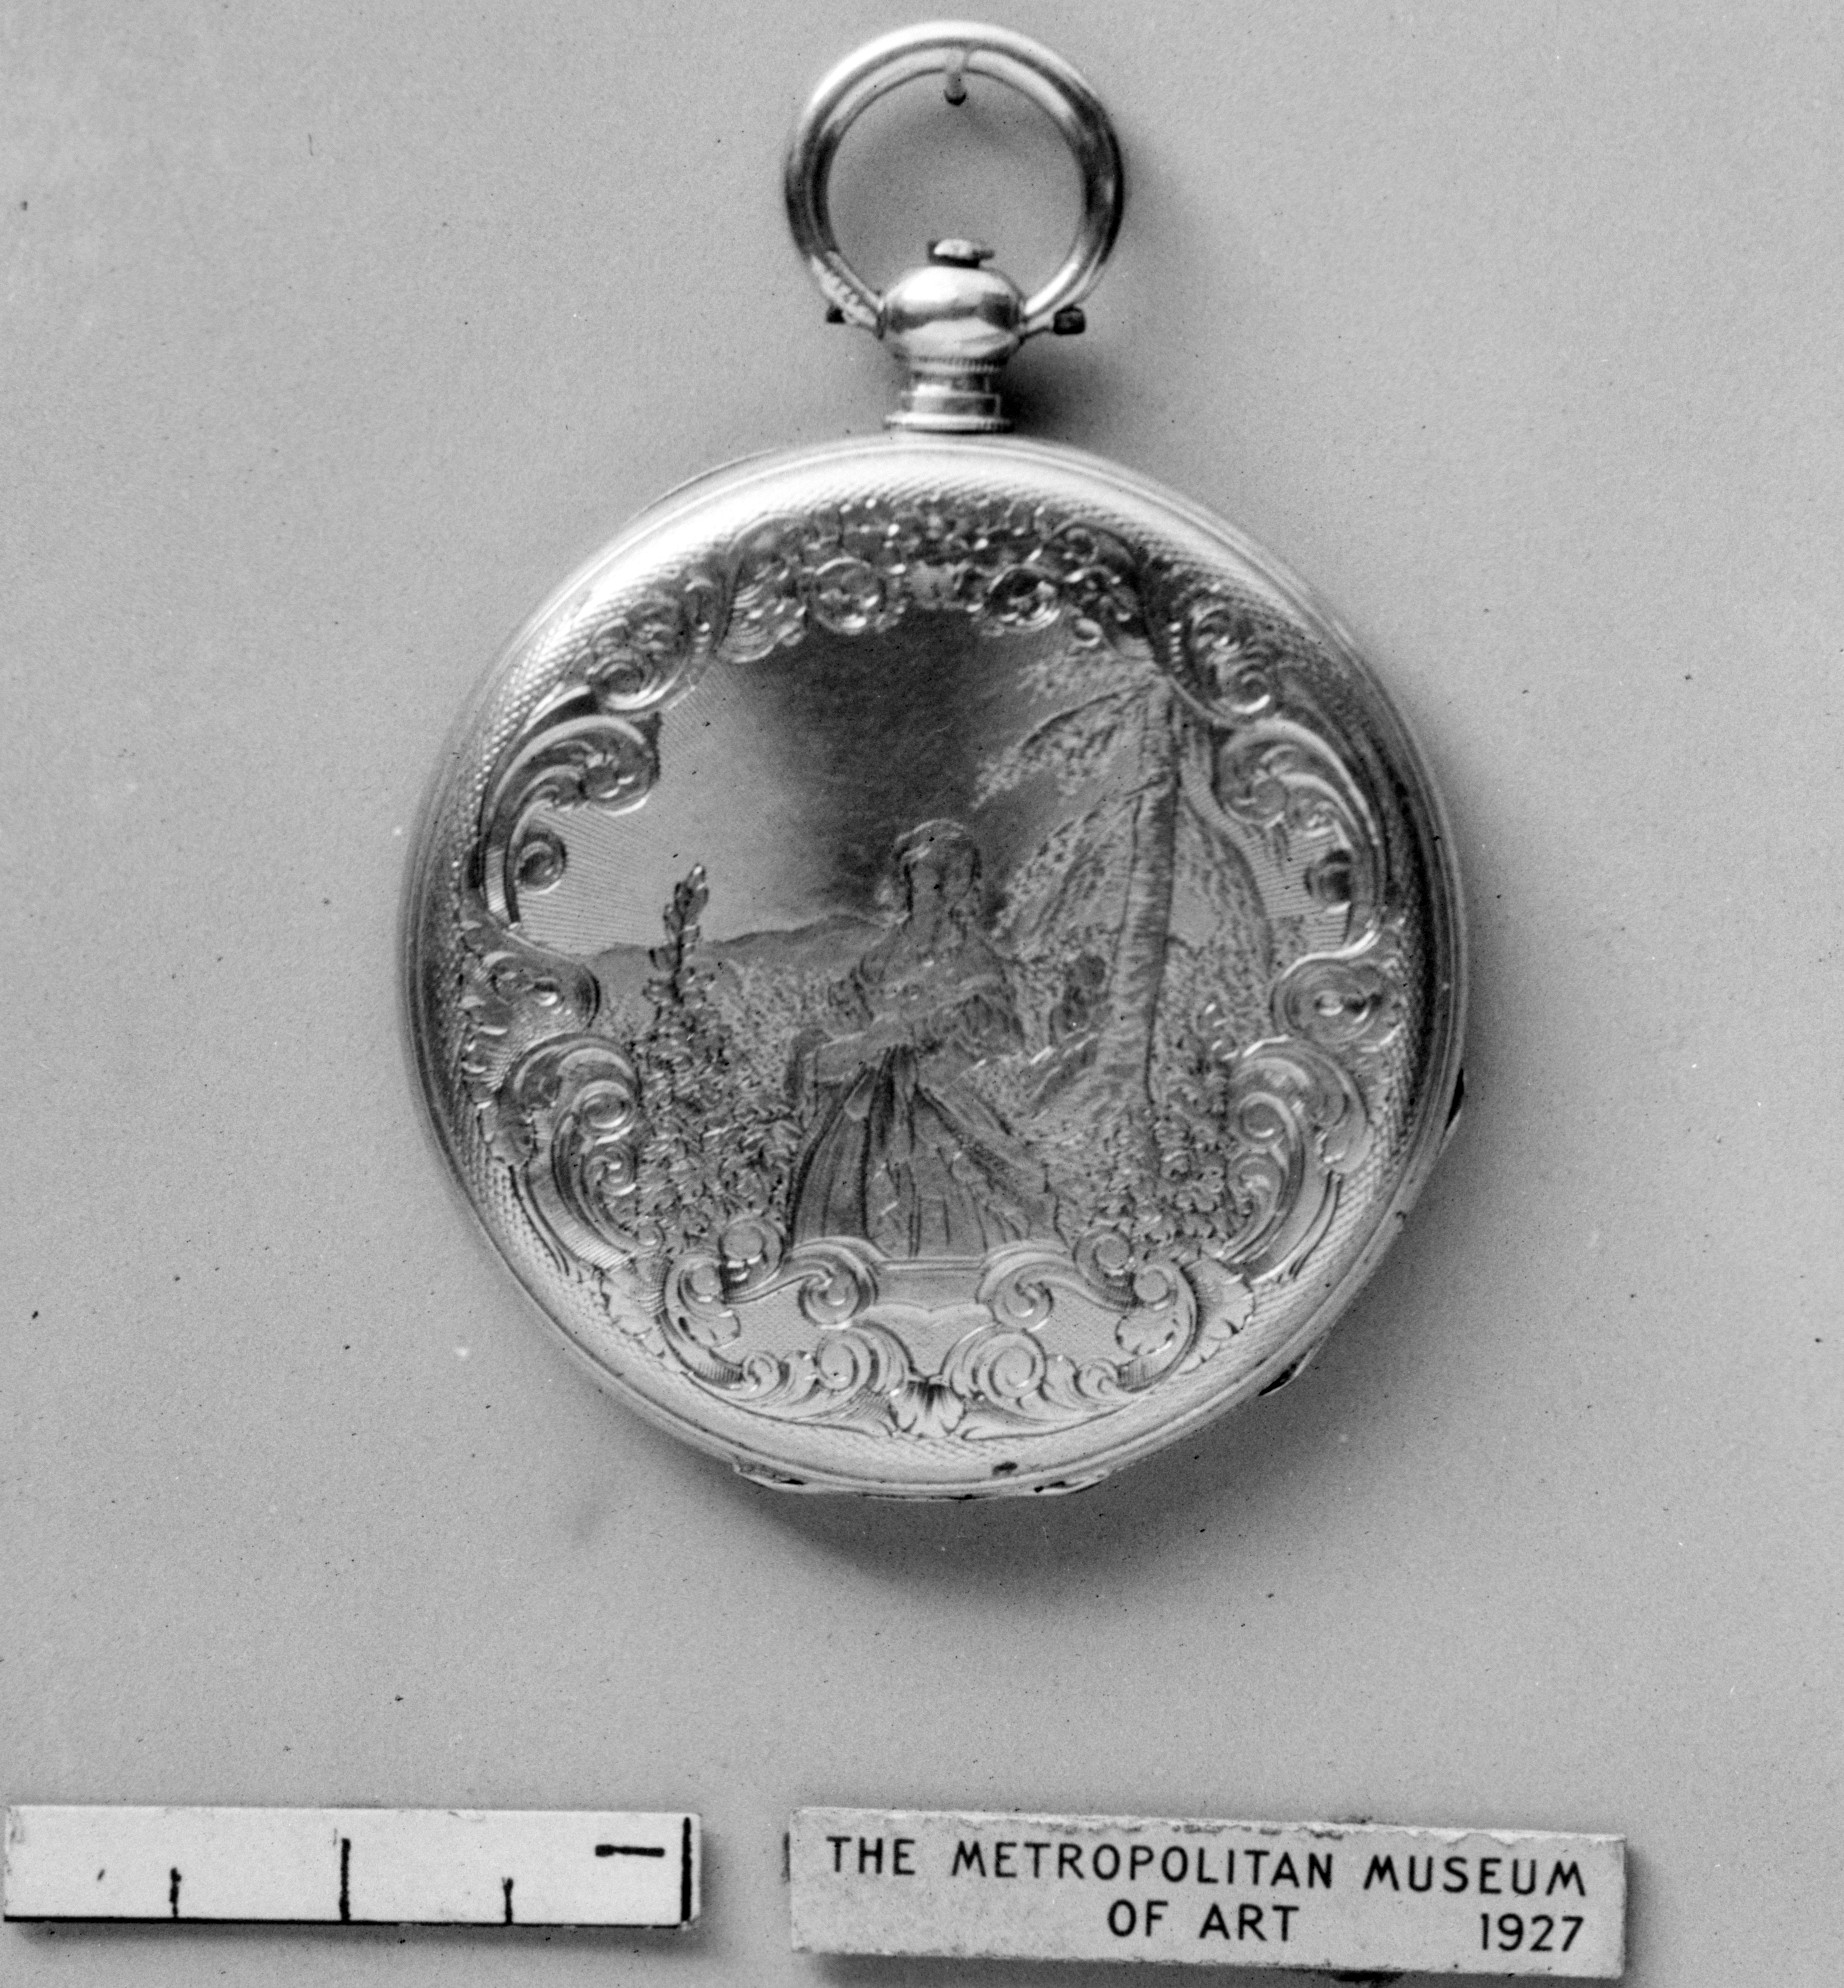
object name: watch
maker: firm of junod frères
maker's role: maker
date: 1830-1850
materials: enamel, gold, steel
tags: women,trees